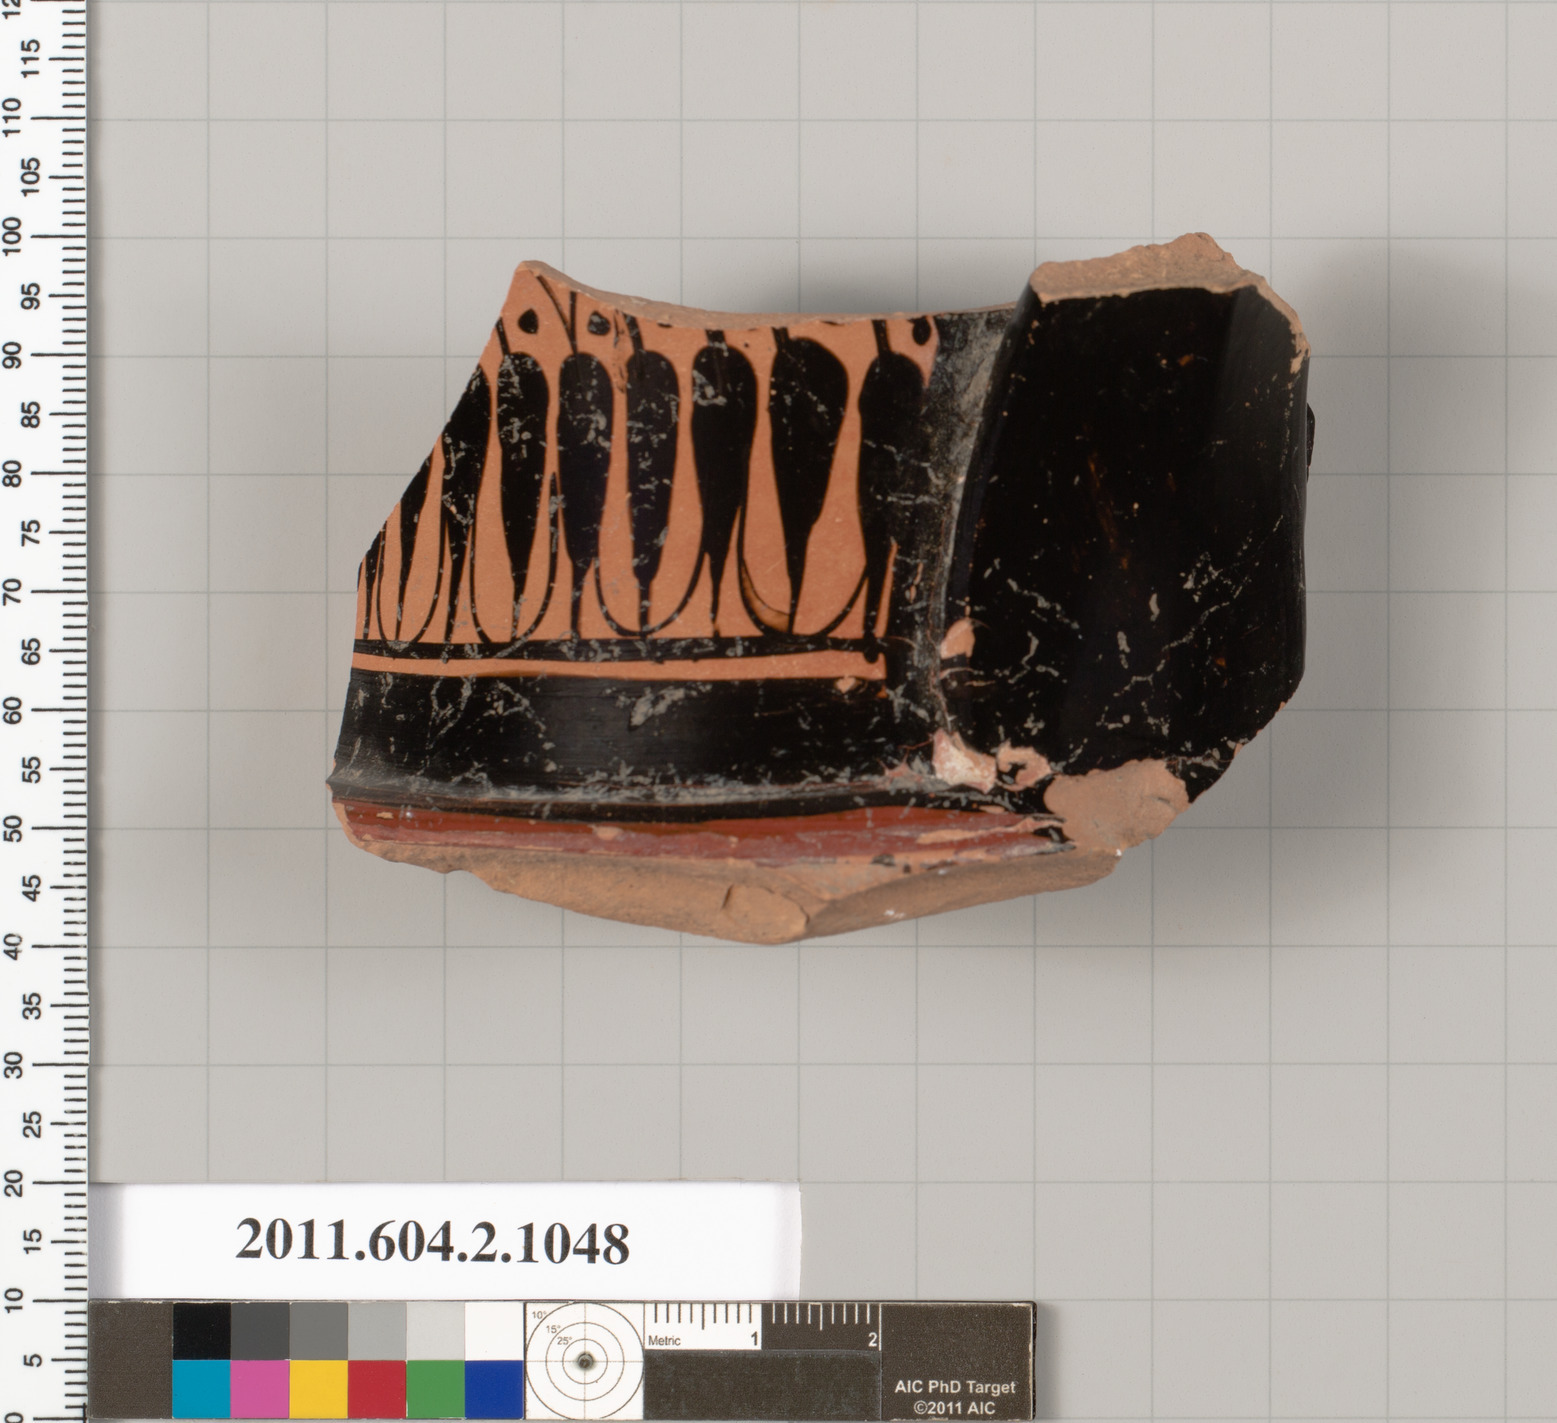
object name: pelike fragment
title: Terracotta fragment of a pelike (jar)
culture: greek, attic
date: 460-440 BCE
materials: terracotta